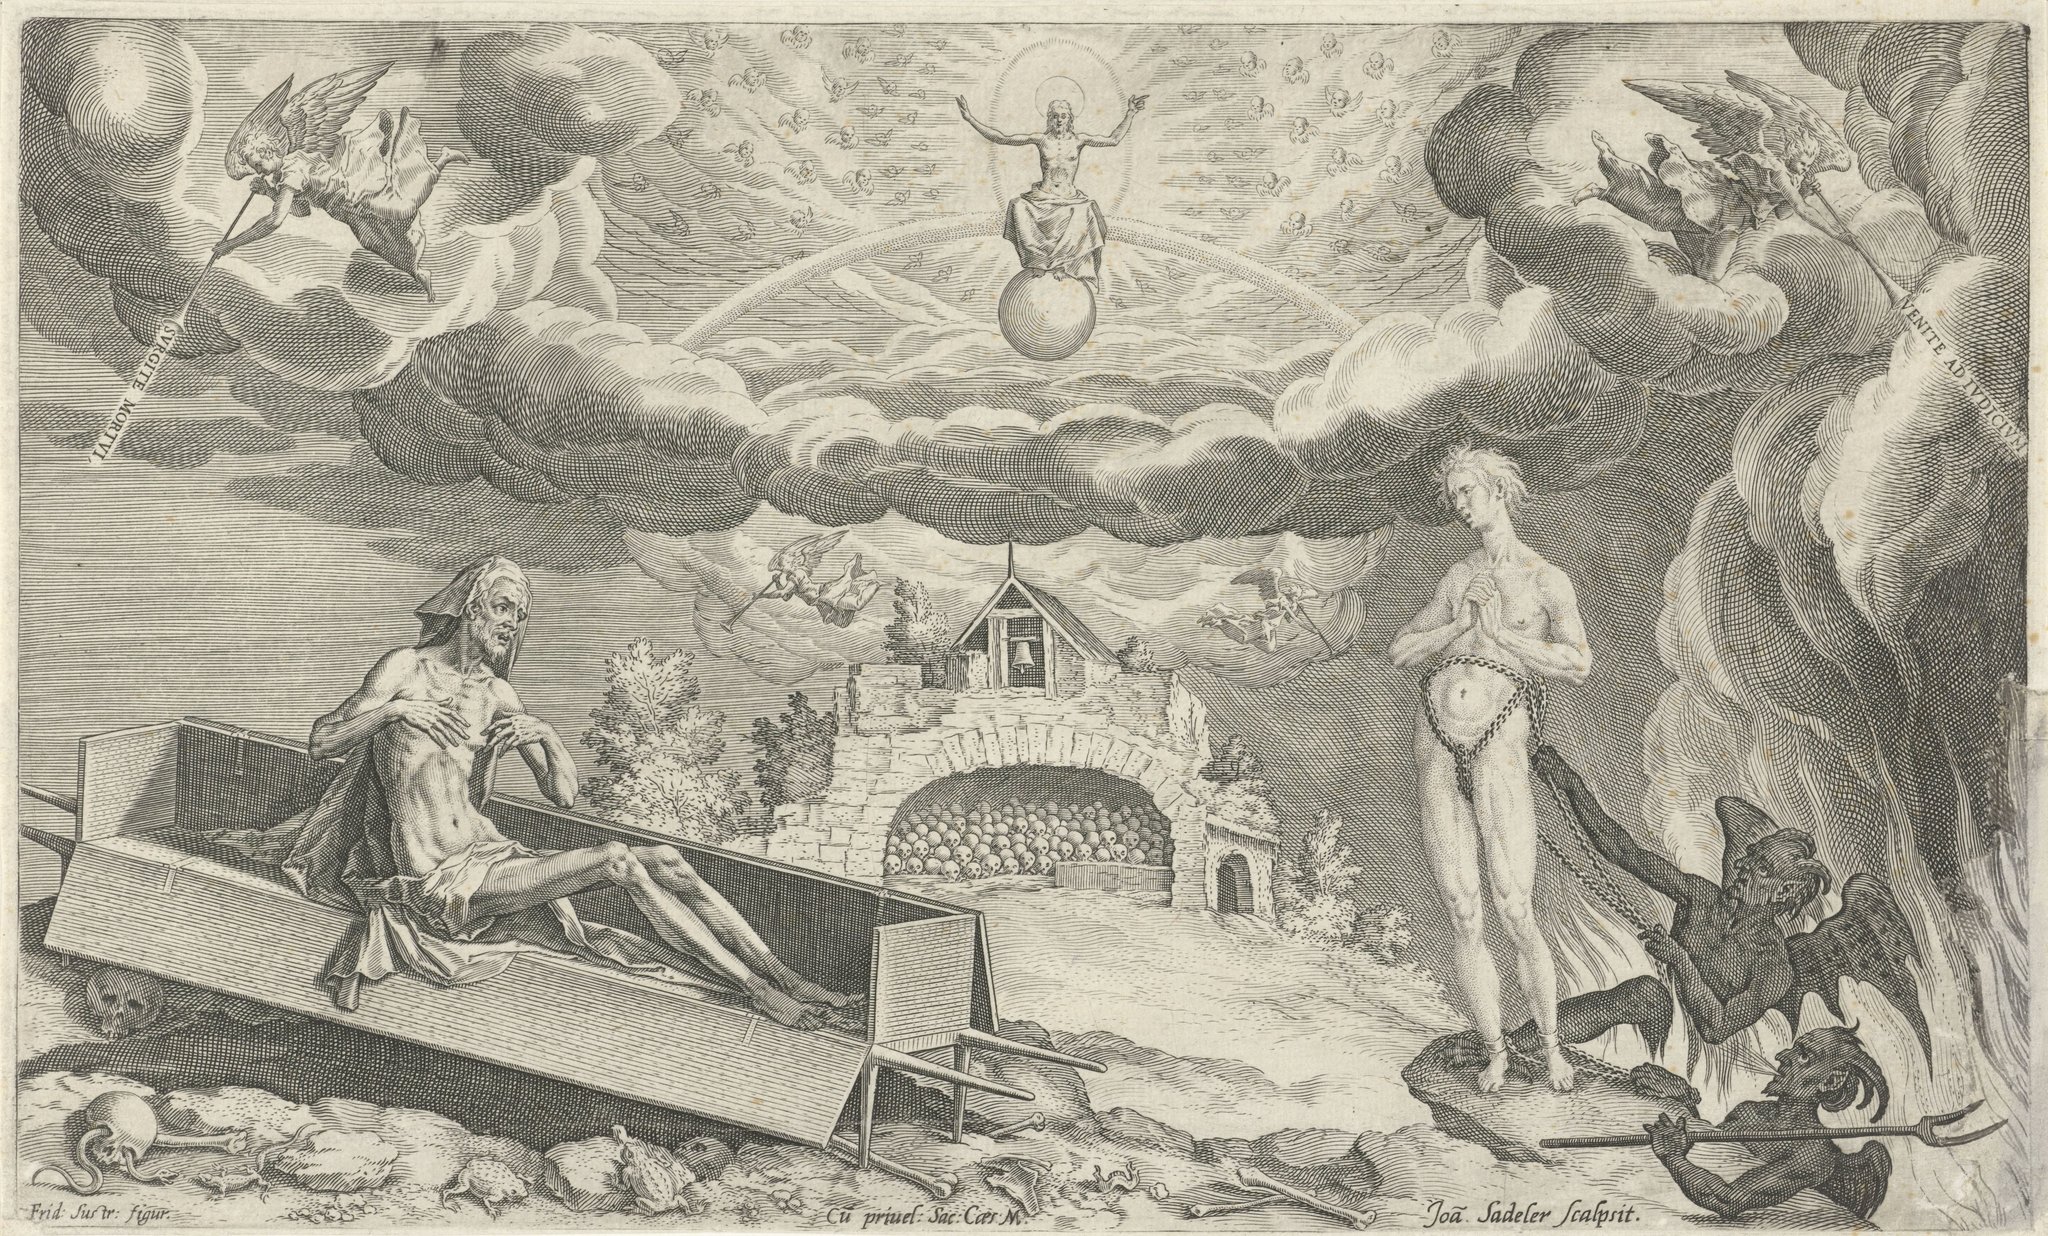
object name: print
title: Laatste Oordeel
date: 1570-1600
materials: paper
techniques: engraving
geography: germany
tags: comprehensive representation of last judgement: christ (with sword and lily), often surrounded by elders and sometimes accompanied by mary and john the baptist, appears in the sky with trumpeting angels (and sometimes angels holding the instruments of the passion); after the resurrection of the dead the blessed are led to heaven by angels, and the damned are dragged into hell by devils, resurrection of the dead ~ last judgement, the fall of the damned ~ last judgement, death's head, skull (symbol of death)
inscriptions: collector's mark: Lugt 240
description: Christus zit op een wereldbol in de wolken, omringd door engelenscharen. Hij oordeelt over de wereld tijdens het Laatste Oordeel. Op de voorgrond rechts zit een man in een doodskist. Hij is herrezen uit de dood. Links wordt een geketende man door duivels naar de hel gevoerd. Op de achtergrond een nis met doodshoofden.